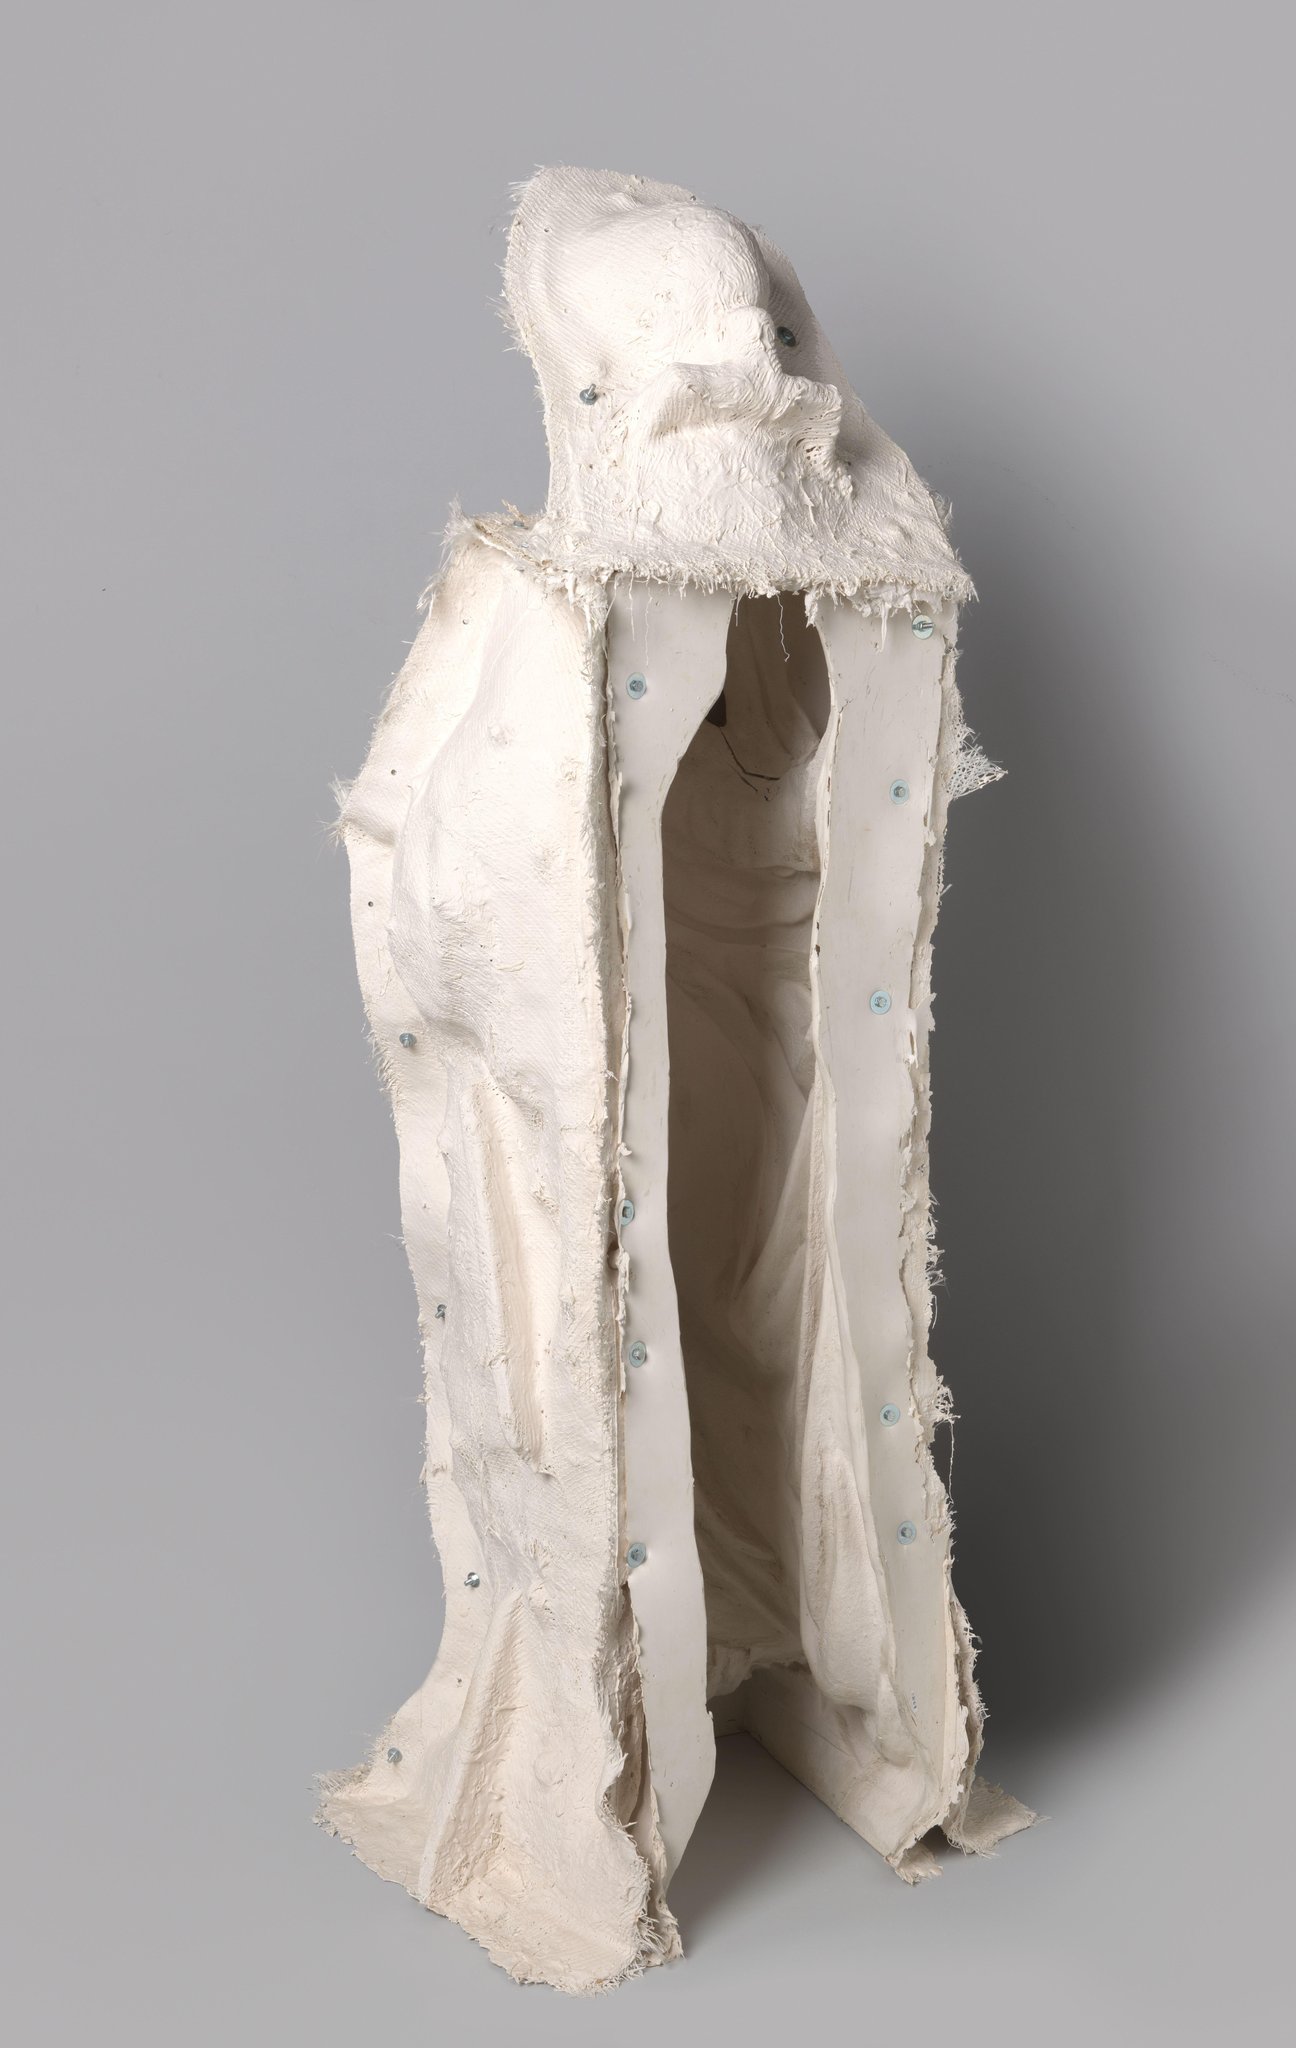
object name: sculpture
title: Vrouwenfiguur ten voeten uit, met spiegel in de hand. Afkomstig van de gevel van de villa van het Rijksmuseum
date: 2000-2020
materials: stone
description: Vrouw ten voeten uit staande met in haar linkerhand een spiegel. Zij draagt een lang gewaad. Bij het beeld hoort een beeld met invnr. BK-TN-3041. Beide beelden horen op een sokkel met invnr. BK-TN-3047 en BK-TN-3048.